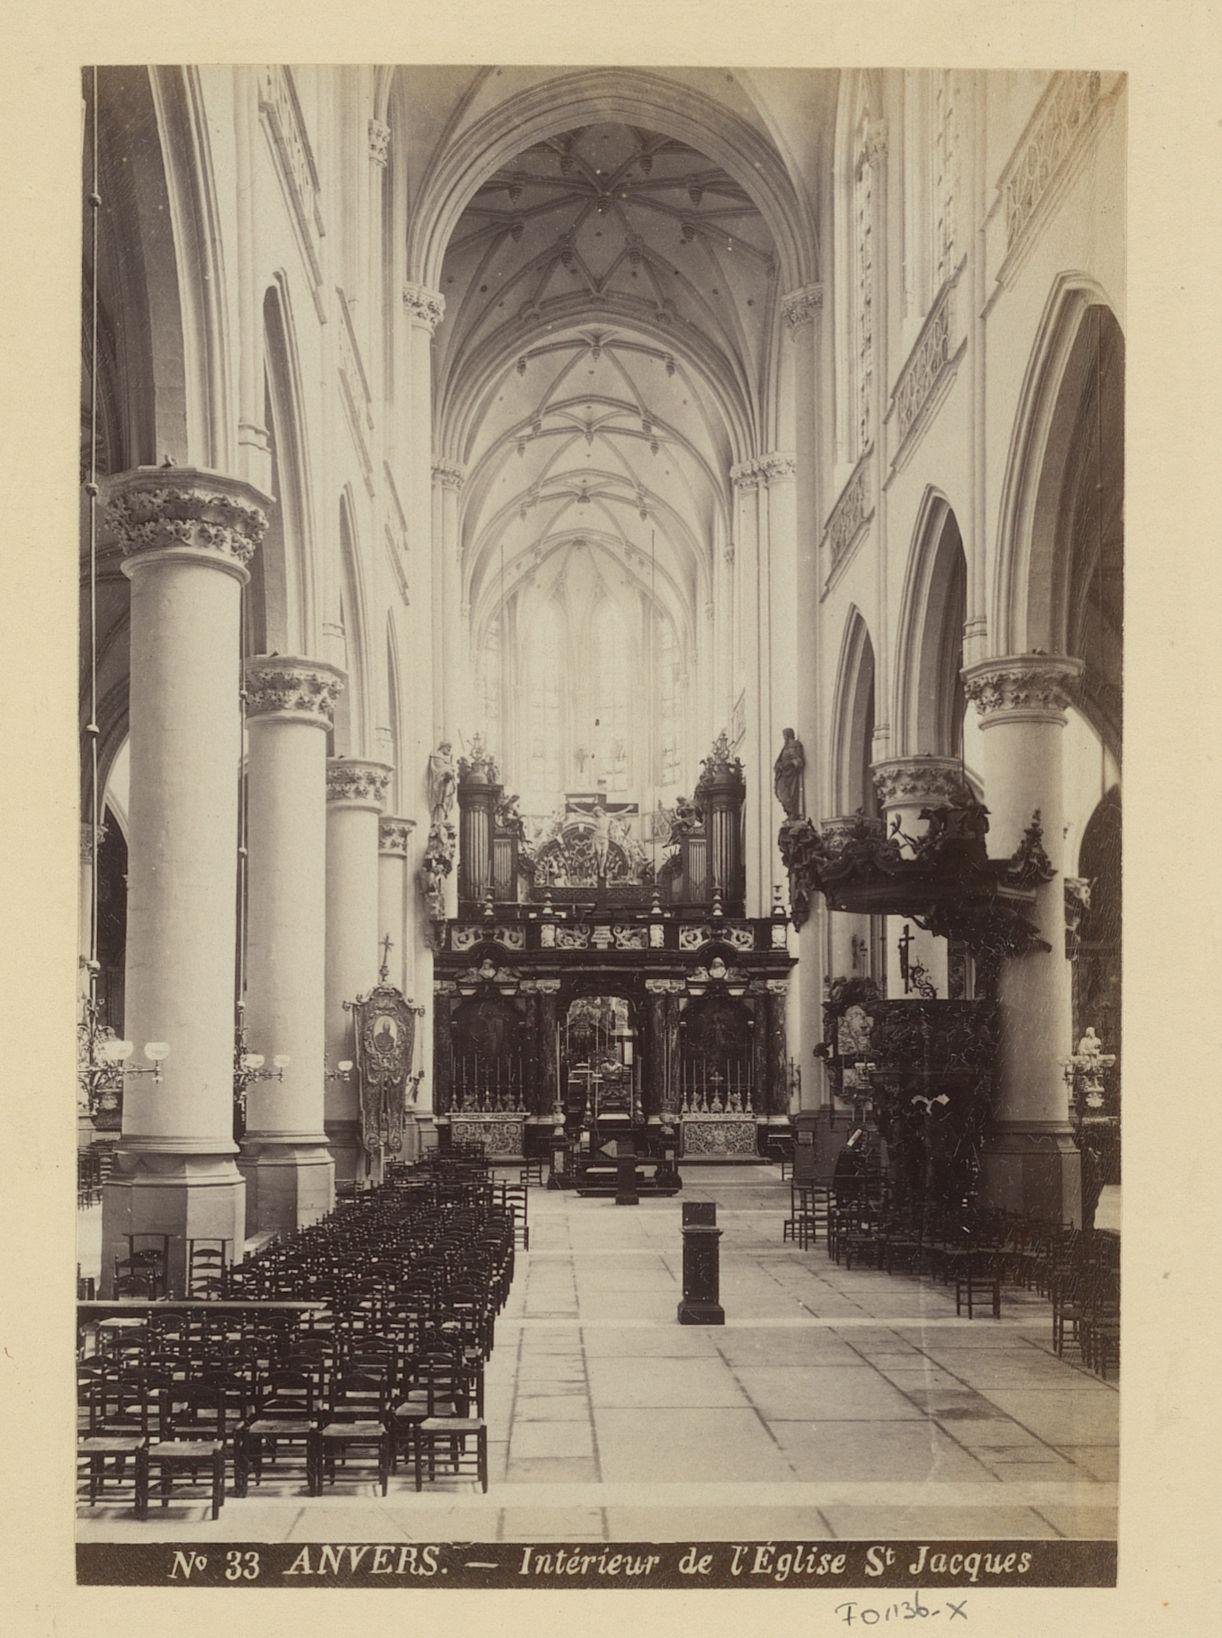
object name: photograph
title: ANVERS. - Intérieur de l'Eglise St Jacques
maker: gustave hermans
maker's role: publisher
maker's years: 1856-1934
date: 1870-1892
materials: photographic support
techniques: albumen print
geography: antwerpen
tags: rood-screen, choir-screen; iconostasis, parts of church interior: nave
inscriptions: number: ‘33’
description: Onderdeel van Fotoalbum met opnames van bezienswaardigheden in België, Duitsland en Noorwegen.